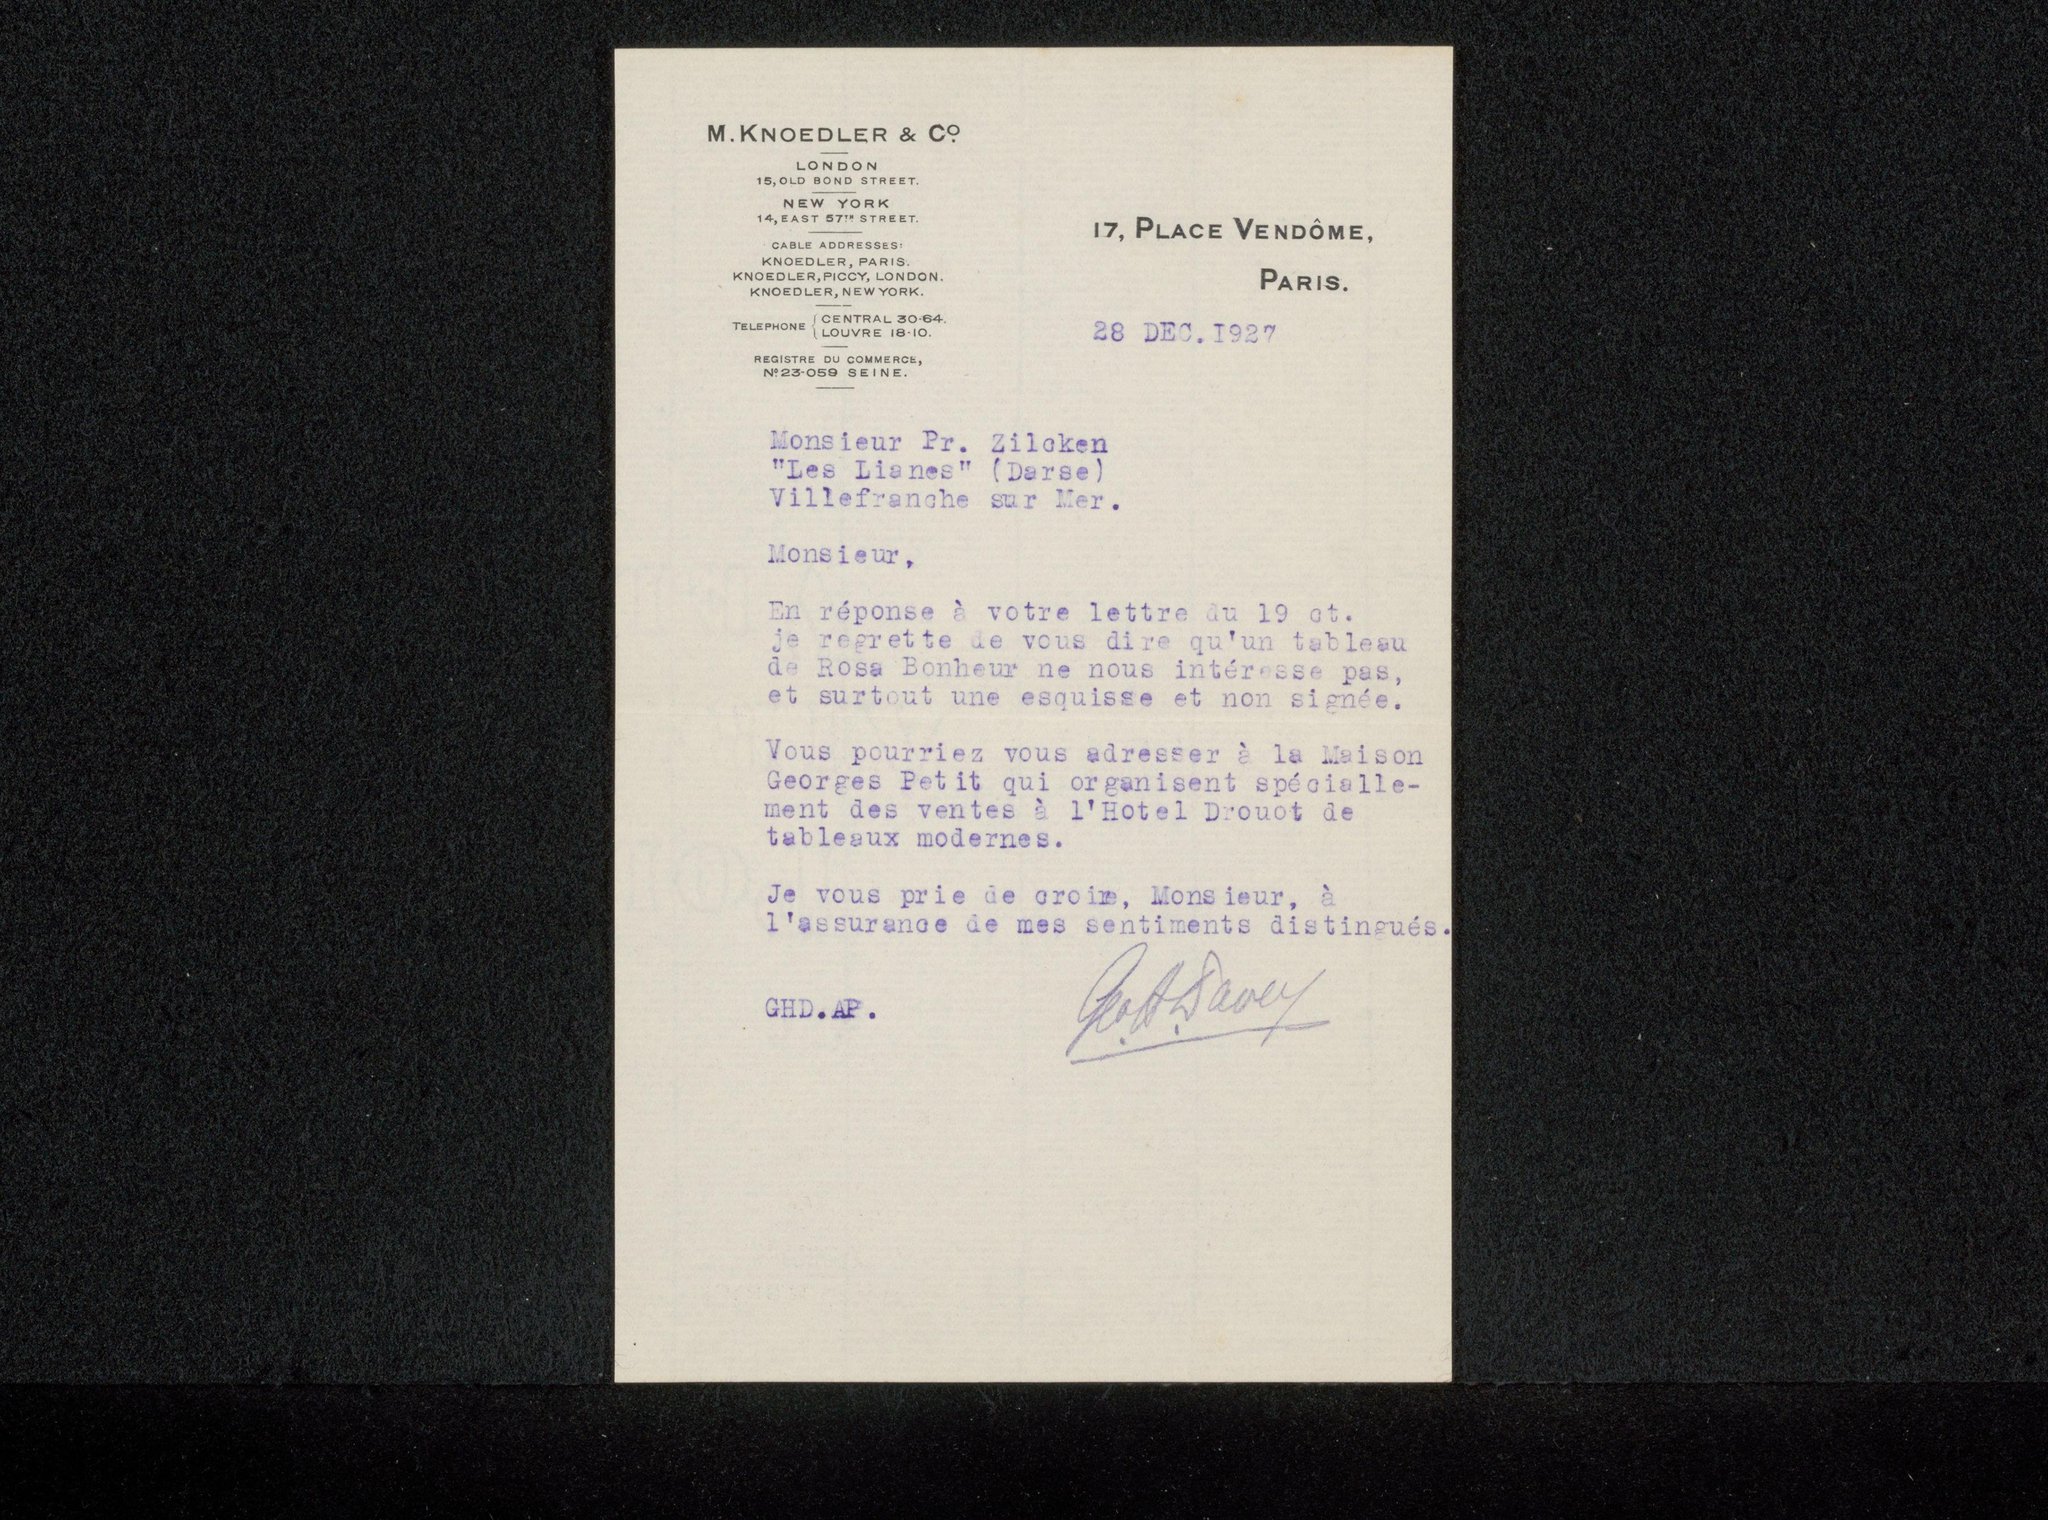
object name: letter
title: Brief aan Philip Zilcken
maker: george henry davey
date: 1927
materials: ink, paper, pencil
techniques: printing, typewriting, writing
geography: paris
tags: painter, print maker, rosa bonheur, the hague, draughtsman, philip zilcken, painting (including book-illumination, miniature-painting)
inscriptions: collector's mark: ‘RPK’, watermark